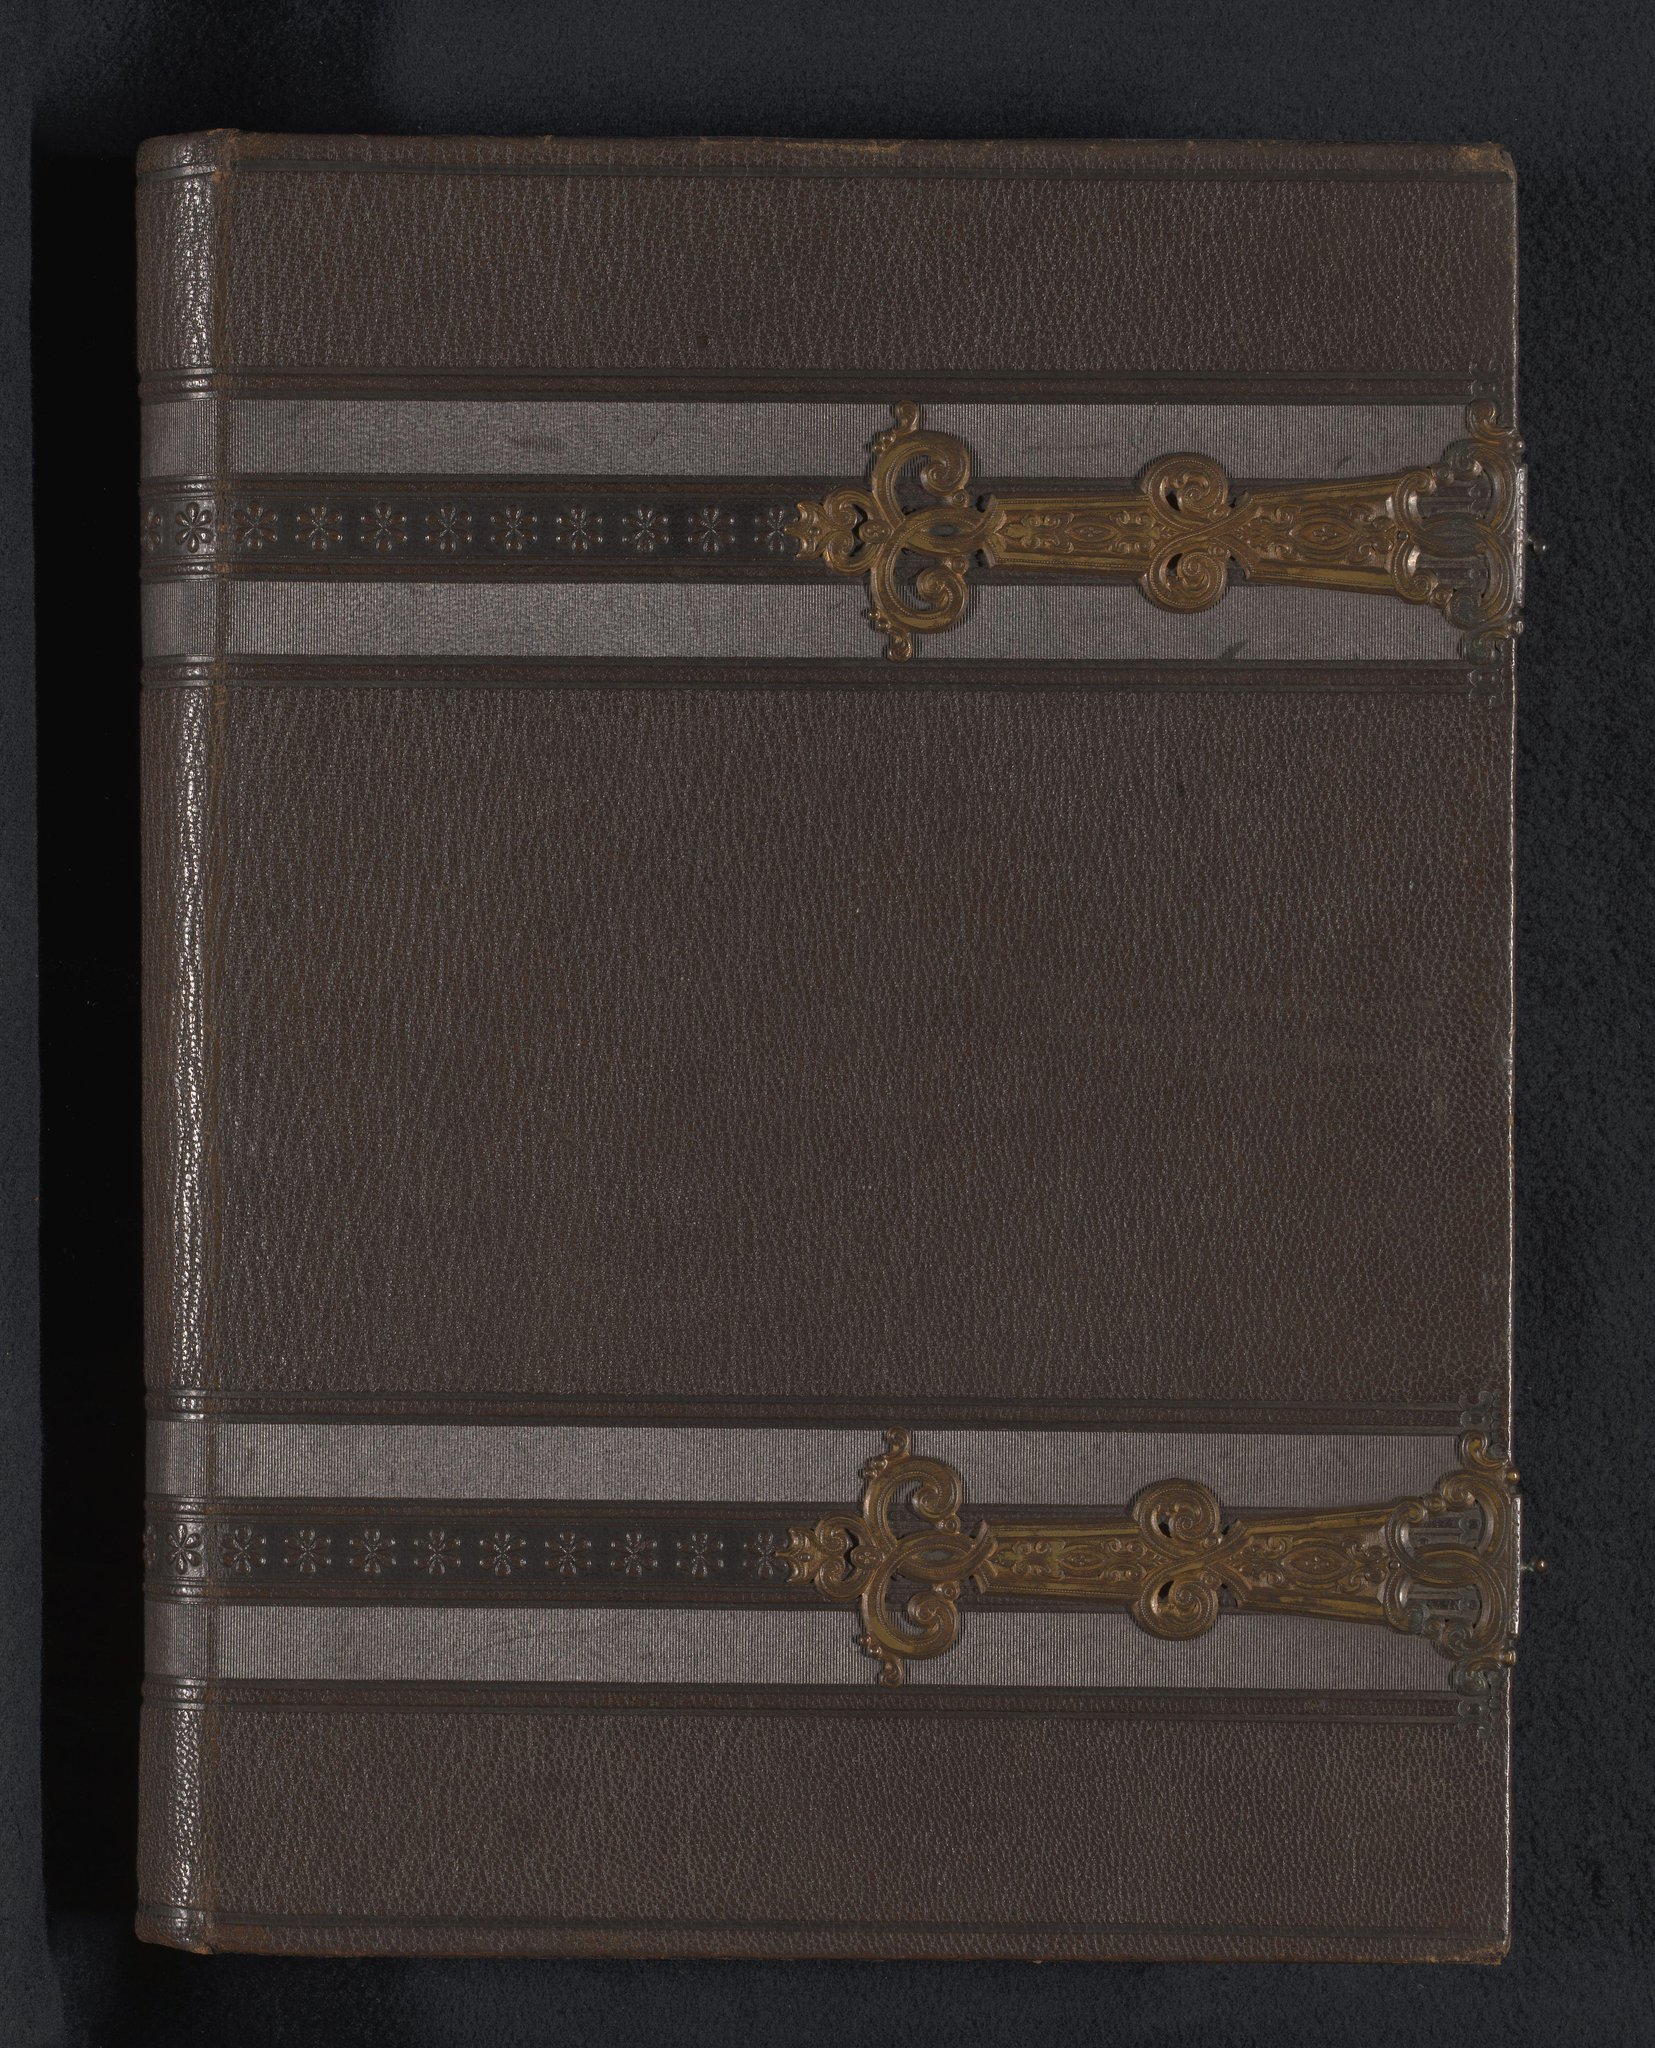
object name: photograph album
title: Nederlands familiealbum van de familie Doyer met 91 foto's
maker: Anonymous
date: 1860-1900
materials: cardboard, leather, metal, paper, photographic support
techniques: albumen print, carbon print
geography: netherlands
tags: historical persons - bb - woman, child, historical persons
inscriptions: collector's mark: ‘DIENST/ VERSPREIDE/ RIJKSKOLLEKTIES/ (...) A 1037’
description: Fotoalbum met 30 pagina's met in totaal 91 foto's. Iedere pagina bevat vier met gepreegde rand omkaderde passe-partouts voor cartes-de-visite. Niet alle passe-partouts in het album zijn gevuld. Afgebeeld zijn portretten van mannen, vrouwen en kinderen, die volgens de documentatie van verzamelaar L.J. Hartkamp allen deel uitmaken van de familie Doyer. Deze naam komt slechts één keer in het album terug, maar het grootste deel van de cartes-de-visite kon niet uit het album worden gehaald om de achterzijde te bekijken. Hierdoor is de fotograaf van de meeste foto's anoniem. De foto's waarvan de fotograaf wel bekend is, zijn gemaakt door Henriette L. Kooy, Jan Antonie Eelsingh, Salomon Goudsmit en Georg Plühr. Op de achterzijde van enkele foto's is de naam Henri te lezen; mogelijk is hij de samensteller van het album geweest.